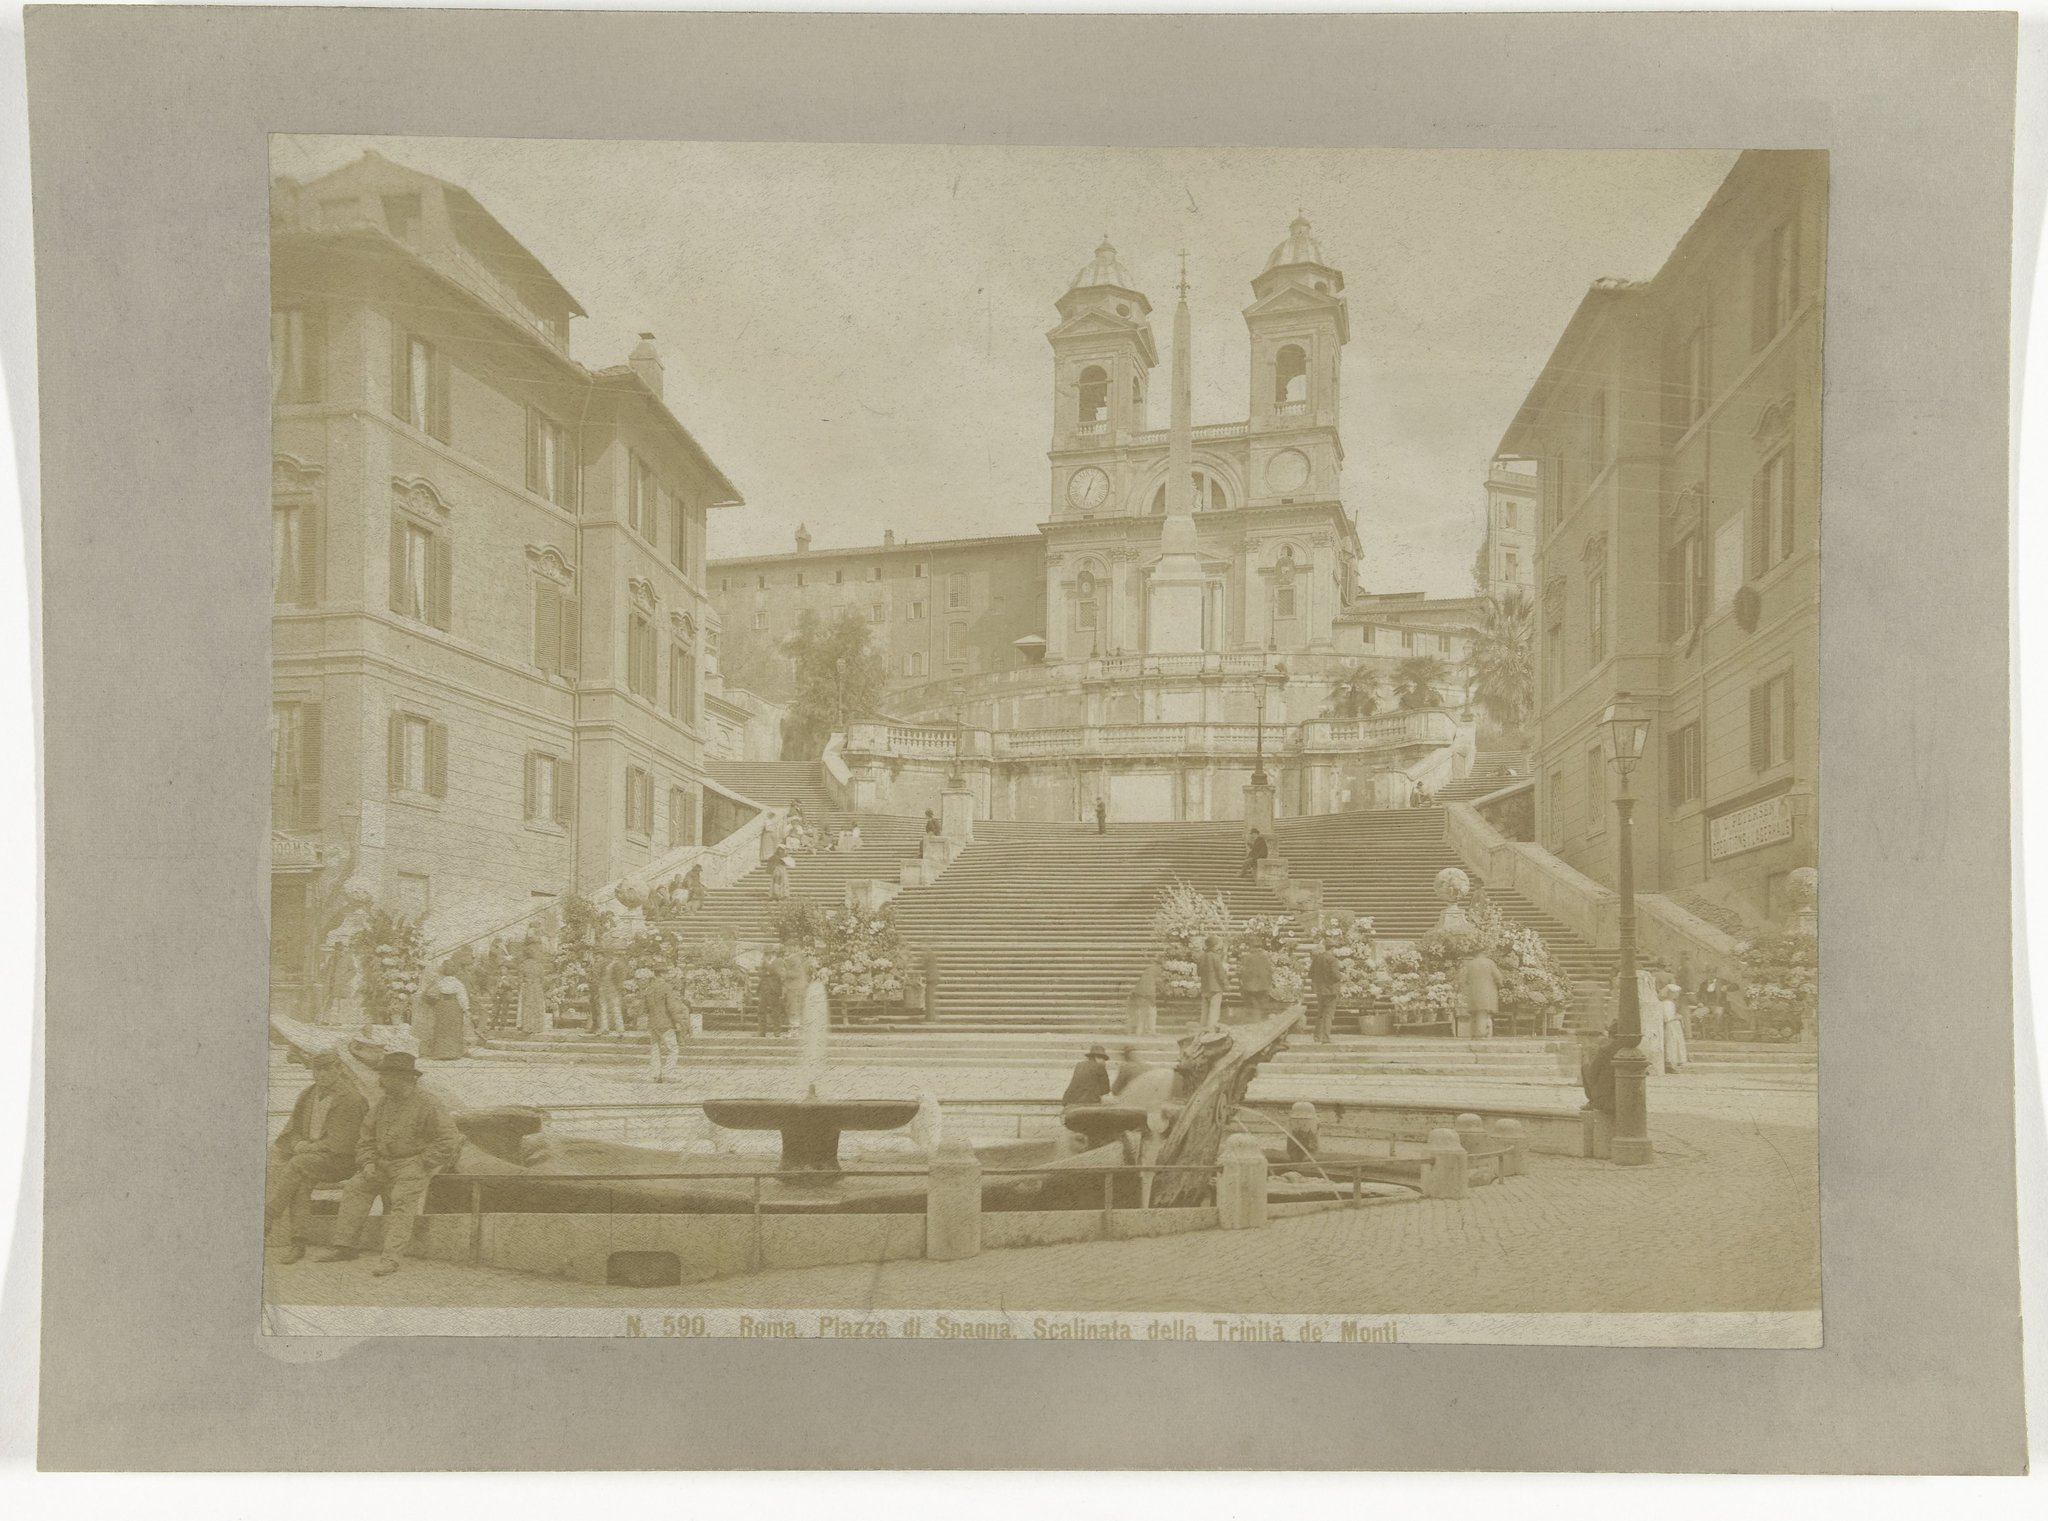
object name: photograph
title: Piazza di Spagna met de Spaanse Trappen naar de Trinità dei Monti, Rome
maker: Anonymous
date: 1880-1895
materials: cardboard, paper, photographic support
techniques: albumen print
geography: rome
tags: spaanse trappen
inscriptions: number: ‘1.’